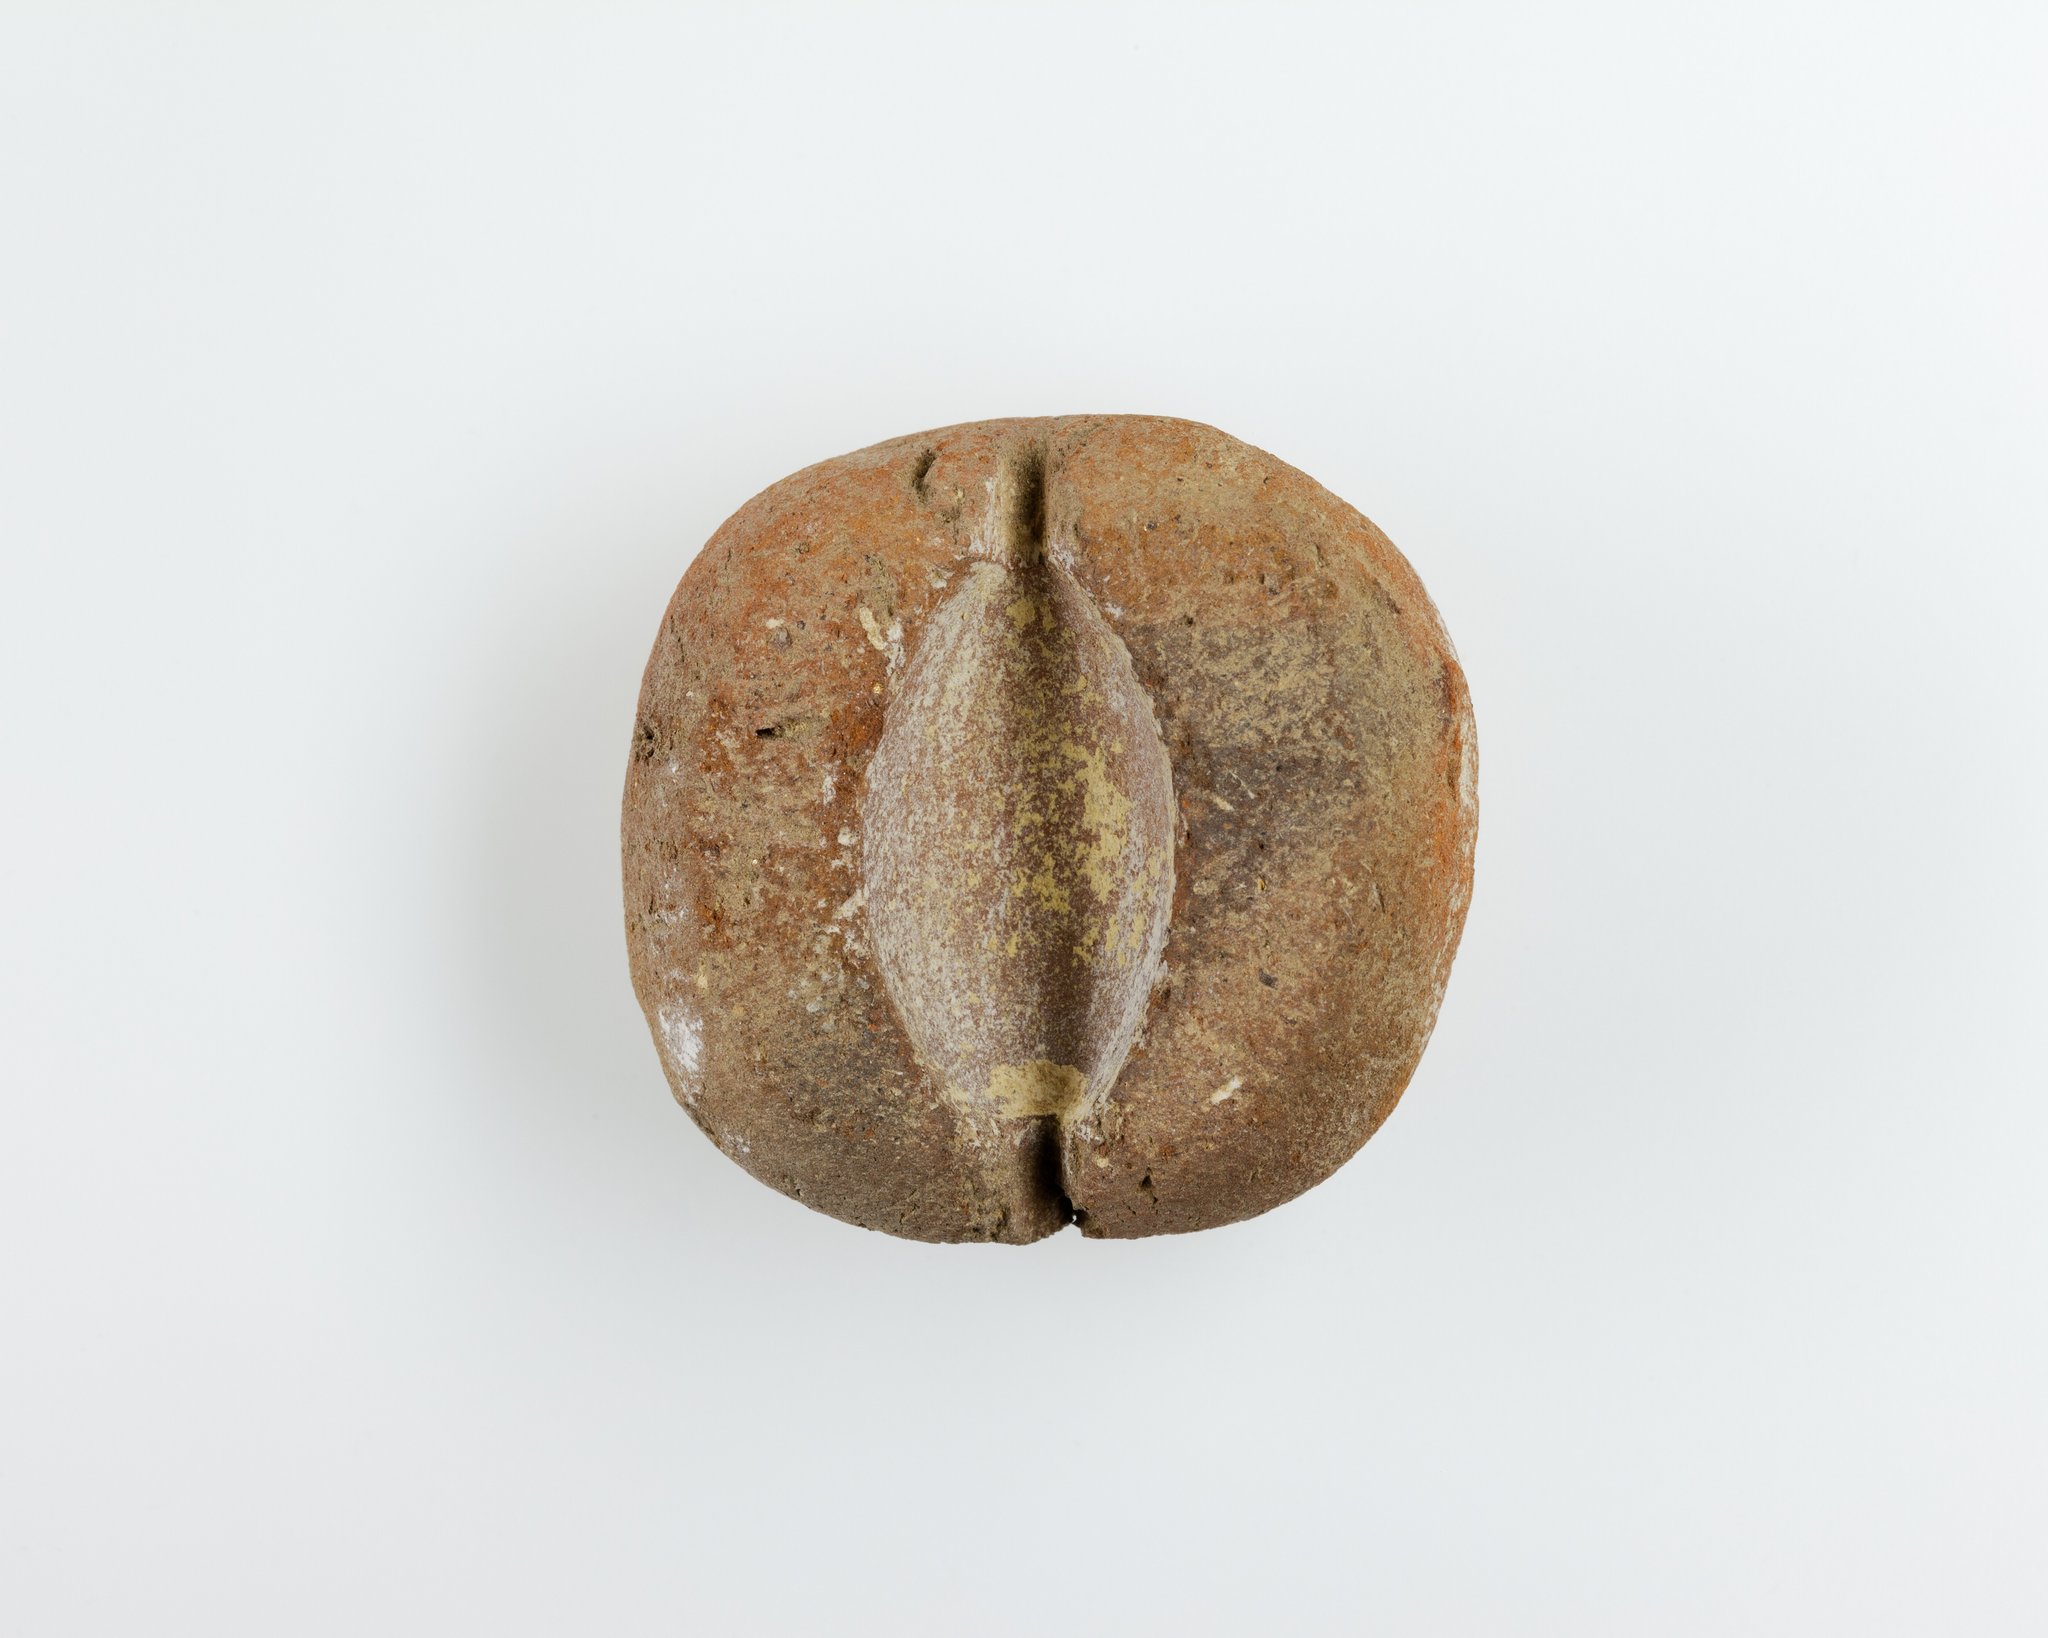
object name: mold, bead. ovoid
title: Mold for Long Ovoid Bead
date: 1390-1352 BCE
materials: pottery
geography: egypt